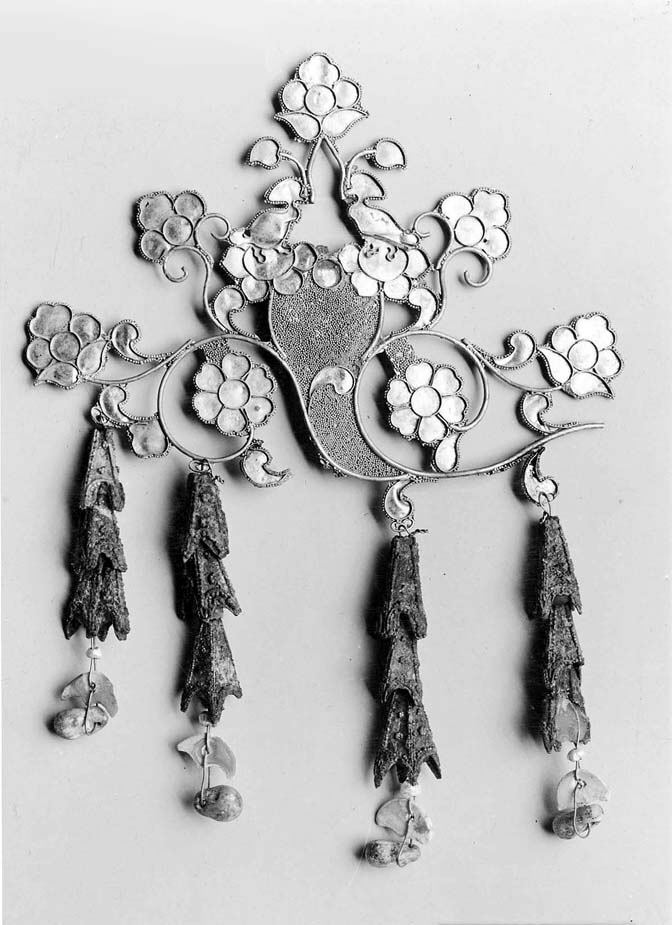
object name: ornament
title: Side Ornament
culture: chinese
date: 618-907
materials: gold